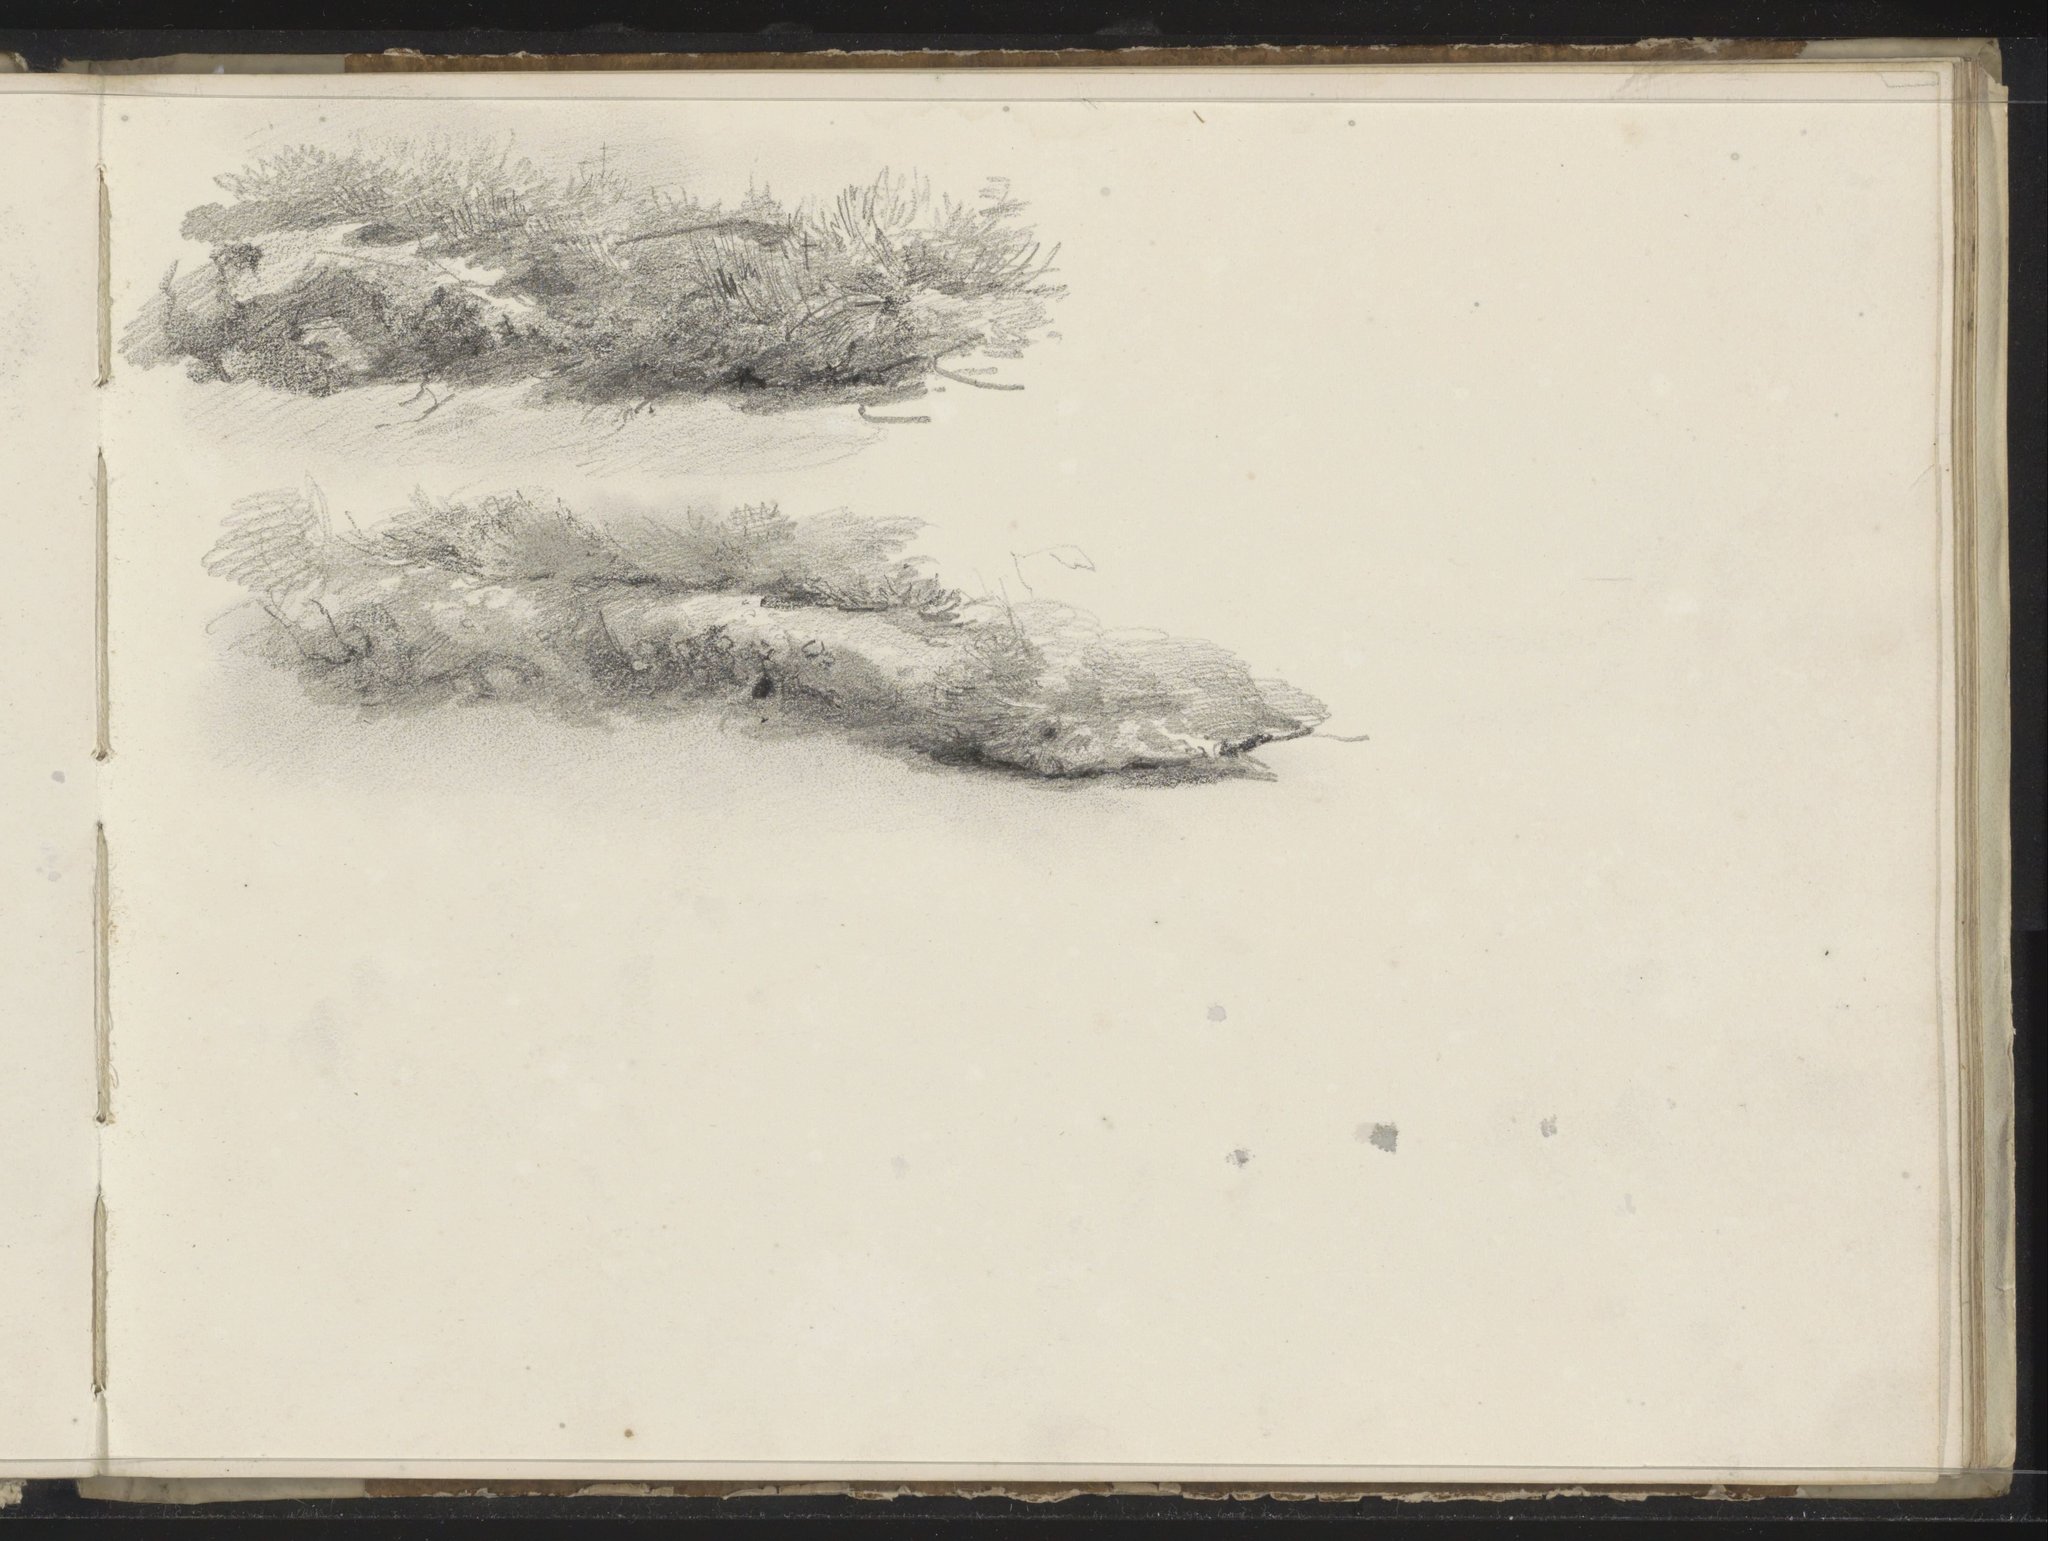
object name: sketchbook leaf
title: Grassen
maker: maria vos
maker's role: draughtsman, painter, print maker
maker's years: 1824-1906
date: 1834-1906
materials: paper, pencil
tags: plants; vegetation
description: Blad 15 recto uit een schetsboek met 39 bladen.